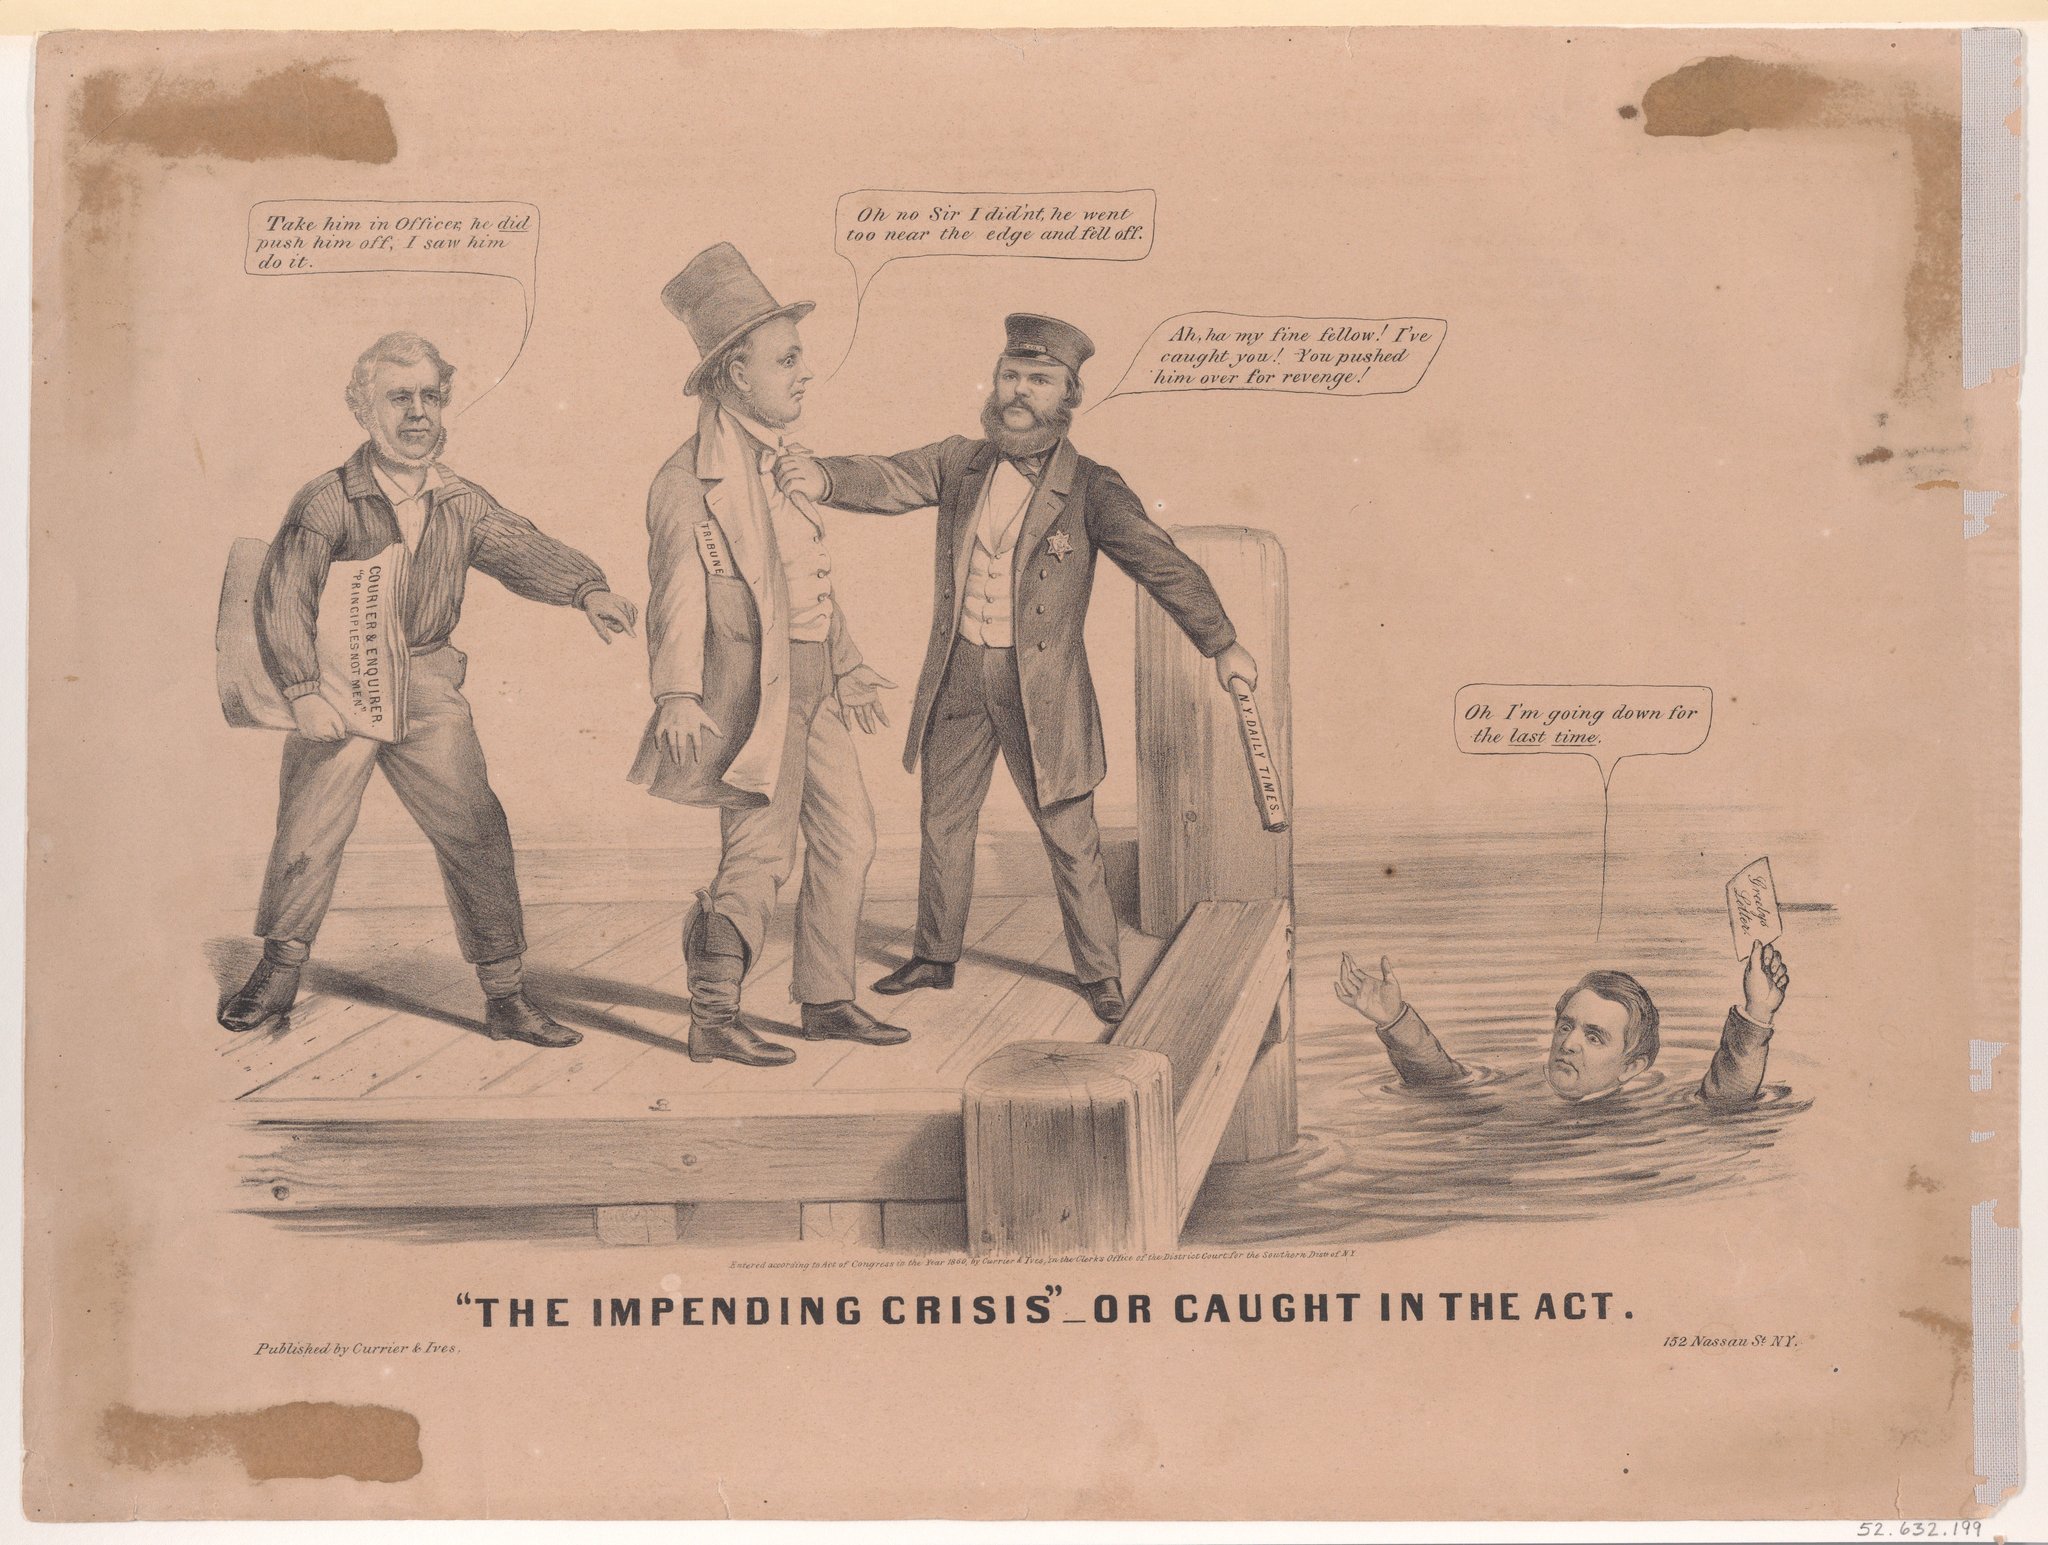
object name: print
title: "The Impending Crisis" – Or Caught in the Act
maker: louis maurer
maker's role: artist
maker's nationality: american, born germany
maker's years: 1832-1932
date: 1860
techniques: lithograph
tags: satire,men,politics